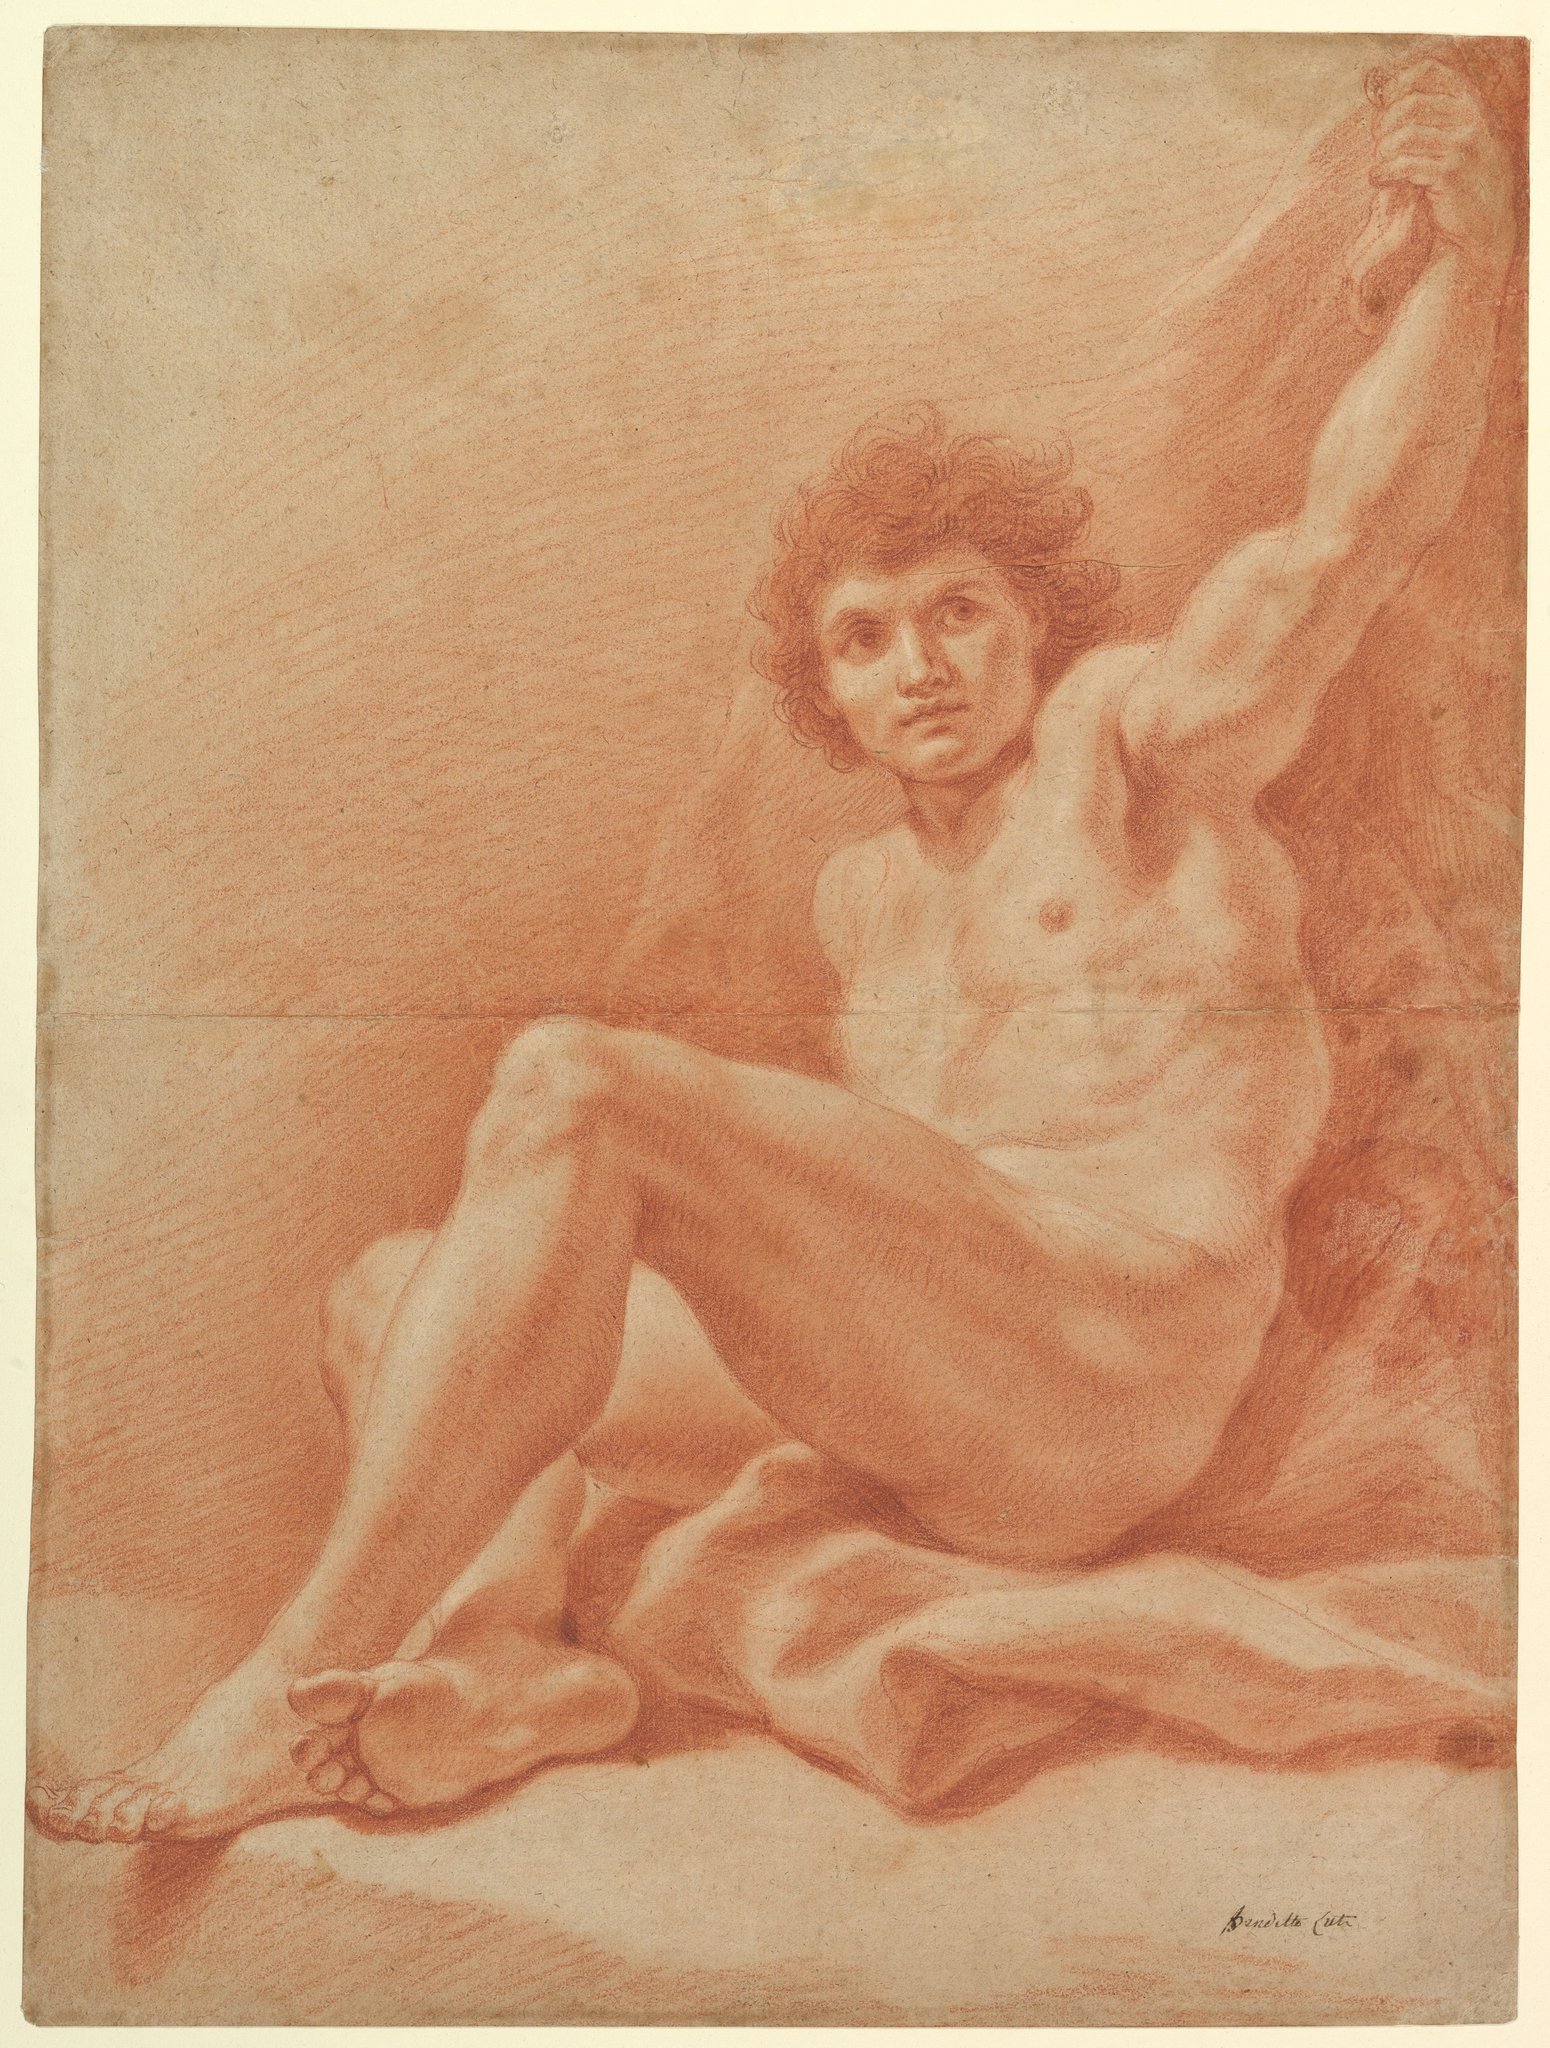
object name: drawing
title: Seated Nude Male Figure (recto); Seated Figure (verso)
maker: benedetto luti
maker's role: artist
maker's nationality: italian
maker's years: 1666-1724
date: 1666-1724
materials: chalk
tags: male nudes